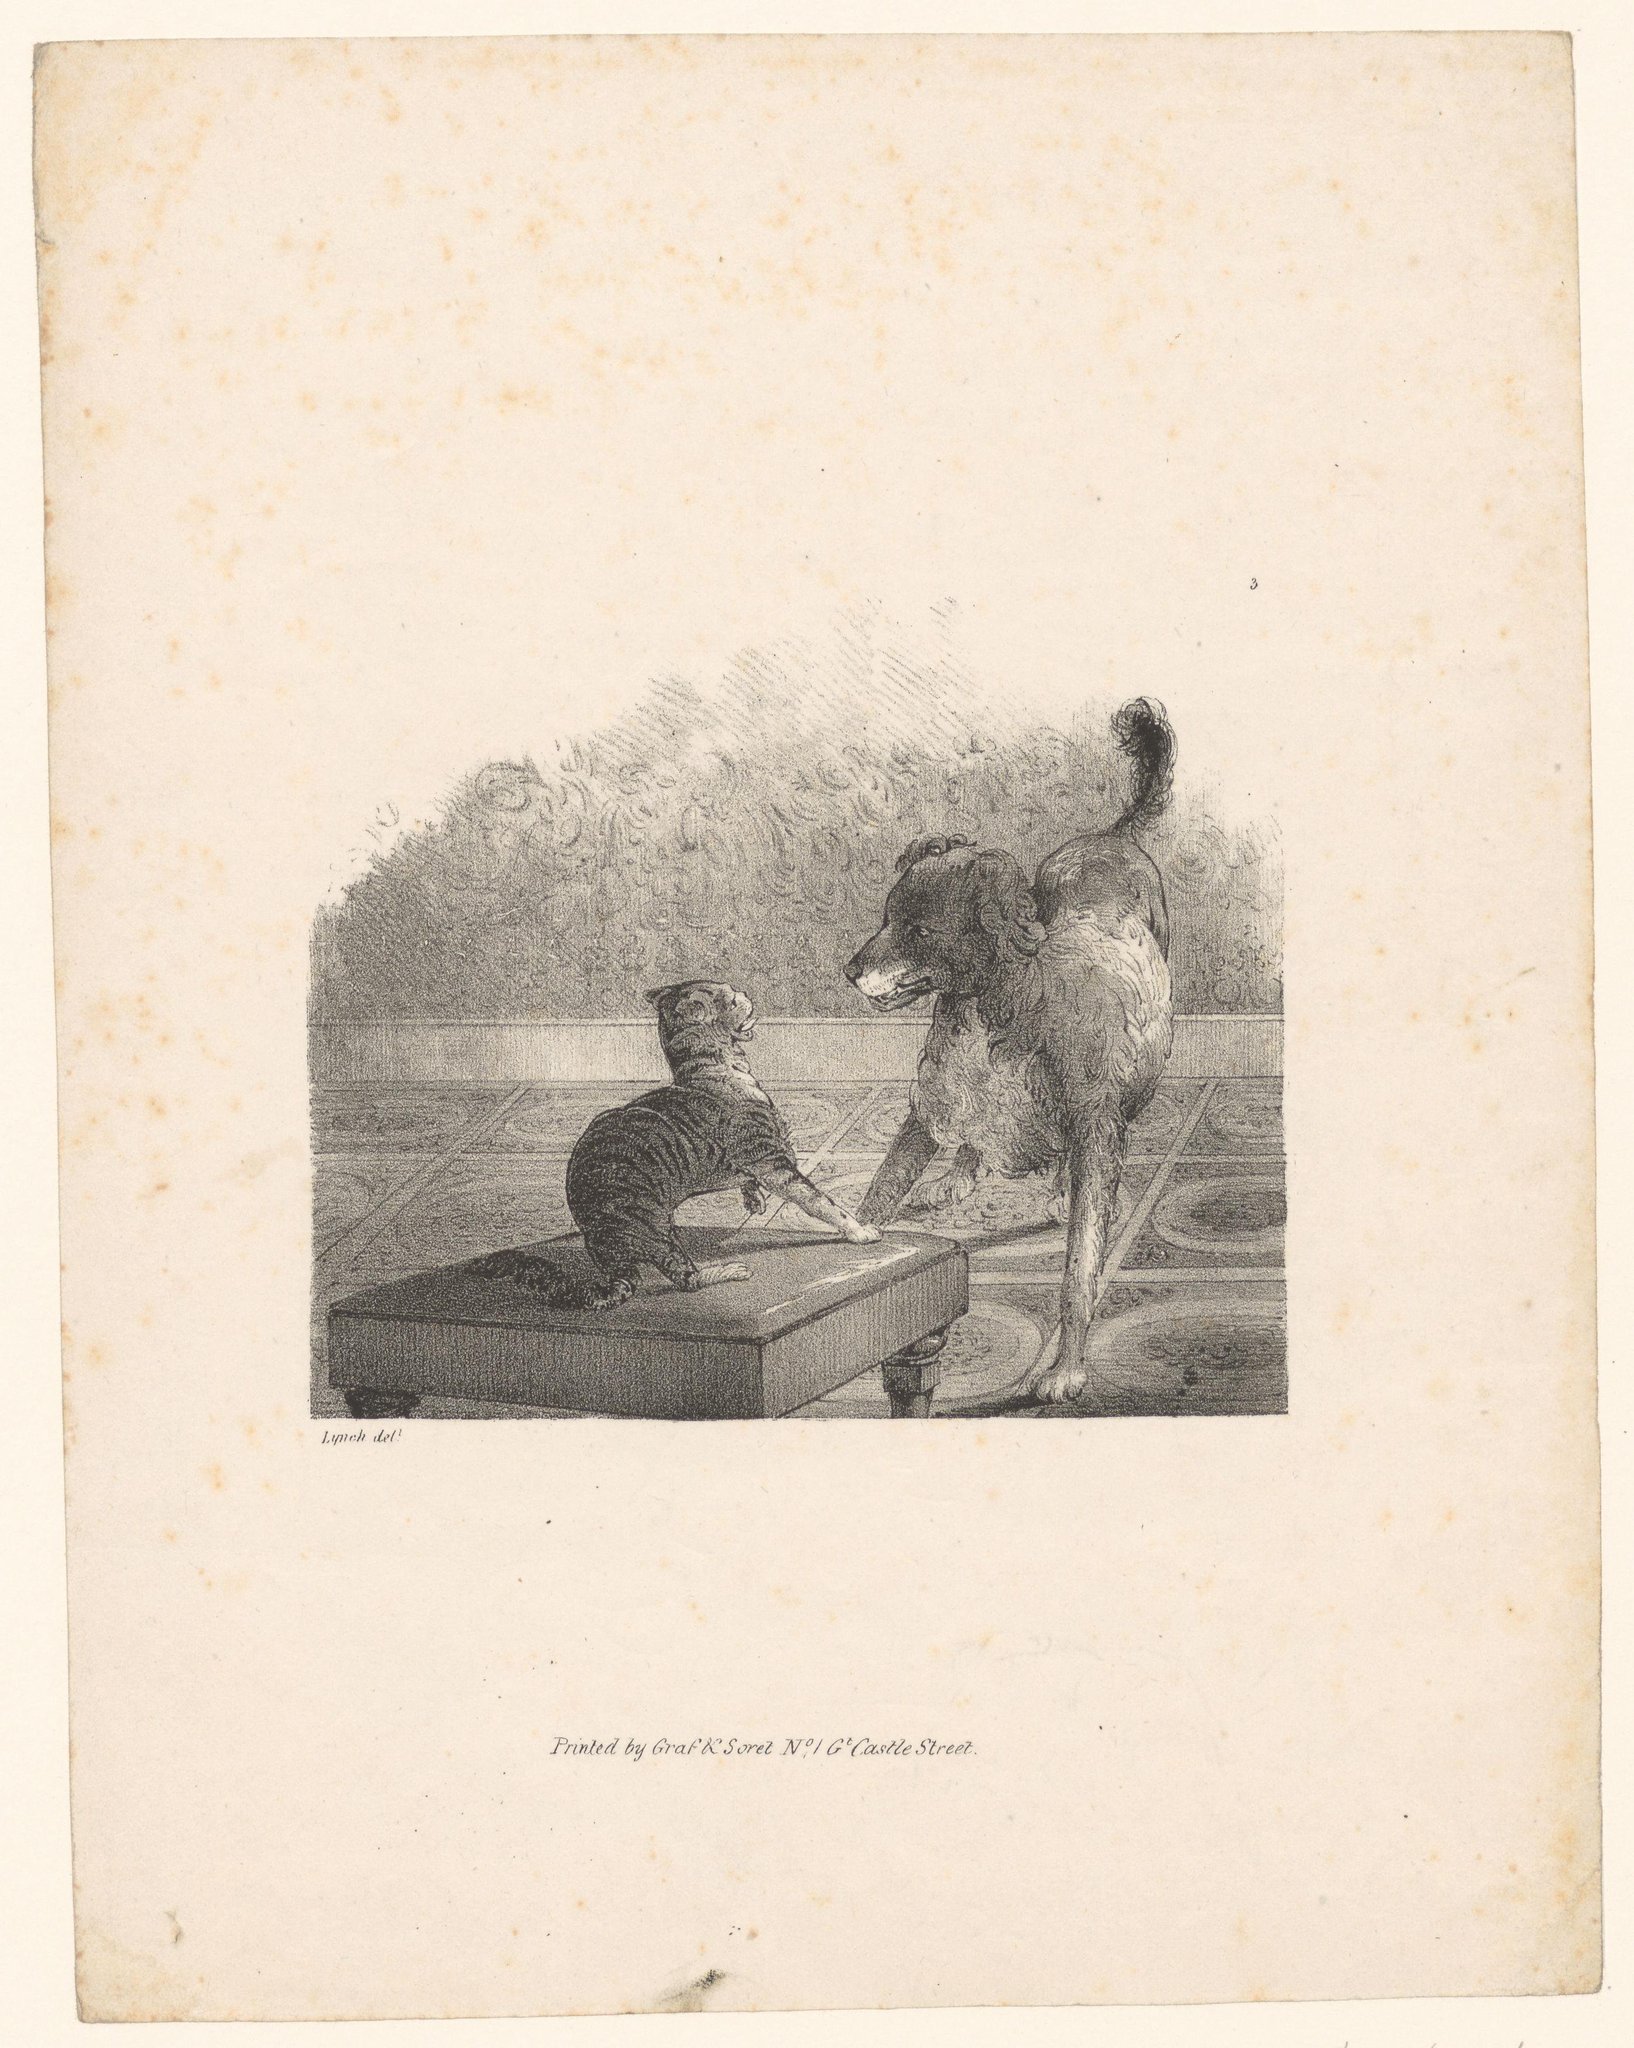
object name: print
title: Voorstellingen van honden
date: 1830-1838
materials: paper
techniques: lithograph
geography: london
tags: cat, dog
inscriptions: collector's mark: Lugt 2233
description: Prent maakt waarschijnlijk deel uit van een serie met diervoorstellingen. Over deze serie is verder niets bekend. Het betreft voornamelijk voorstellingen van honden.